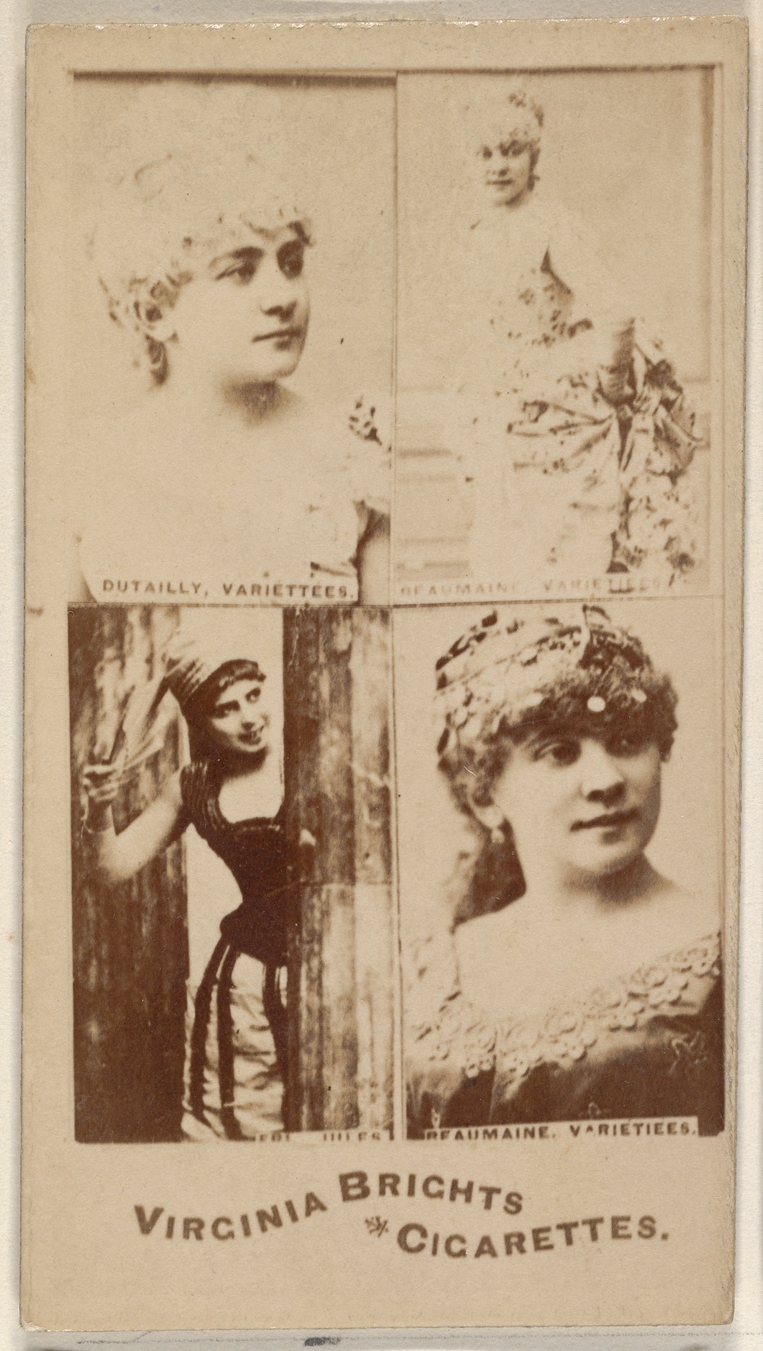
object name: photograph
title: Dutailly, Variettees/ Beaumaine, Variettees/ Beaumaine, Variettees, from the Actors and Actresses series (N45, Type 4) for Virginia Brights Cigarettes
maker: allen & ginter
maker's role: publisher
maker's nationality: american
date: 1888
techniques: albumen silver print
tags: portraits,women,actresses